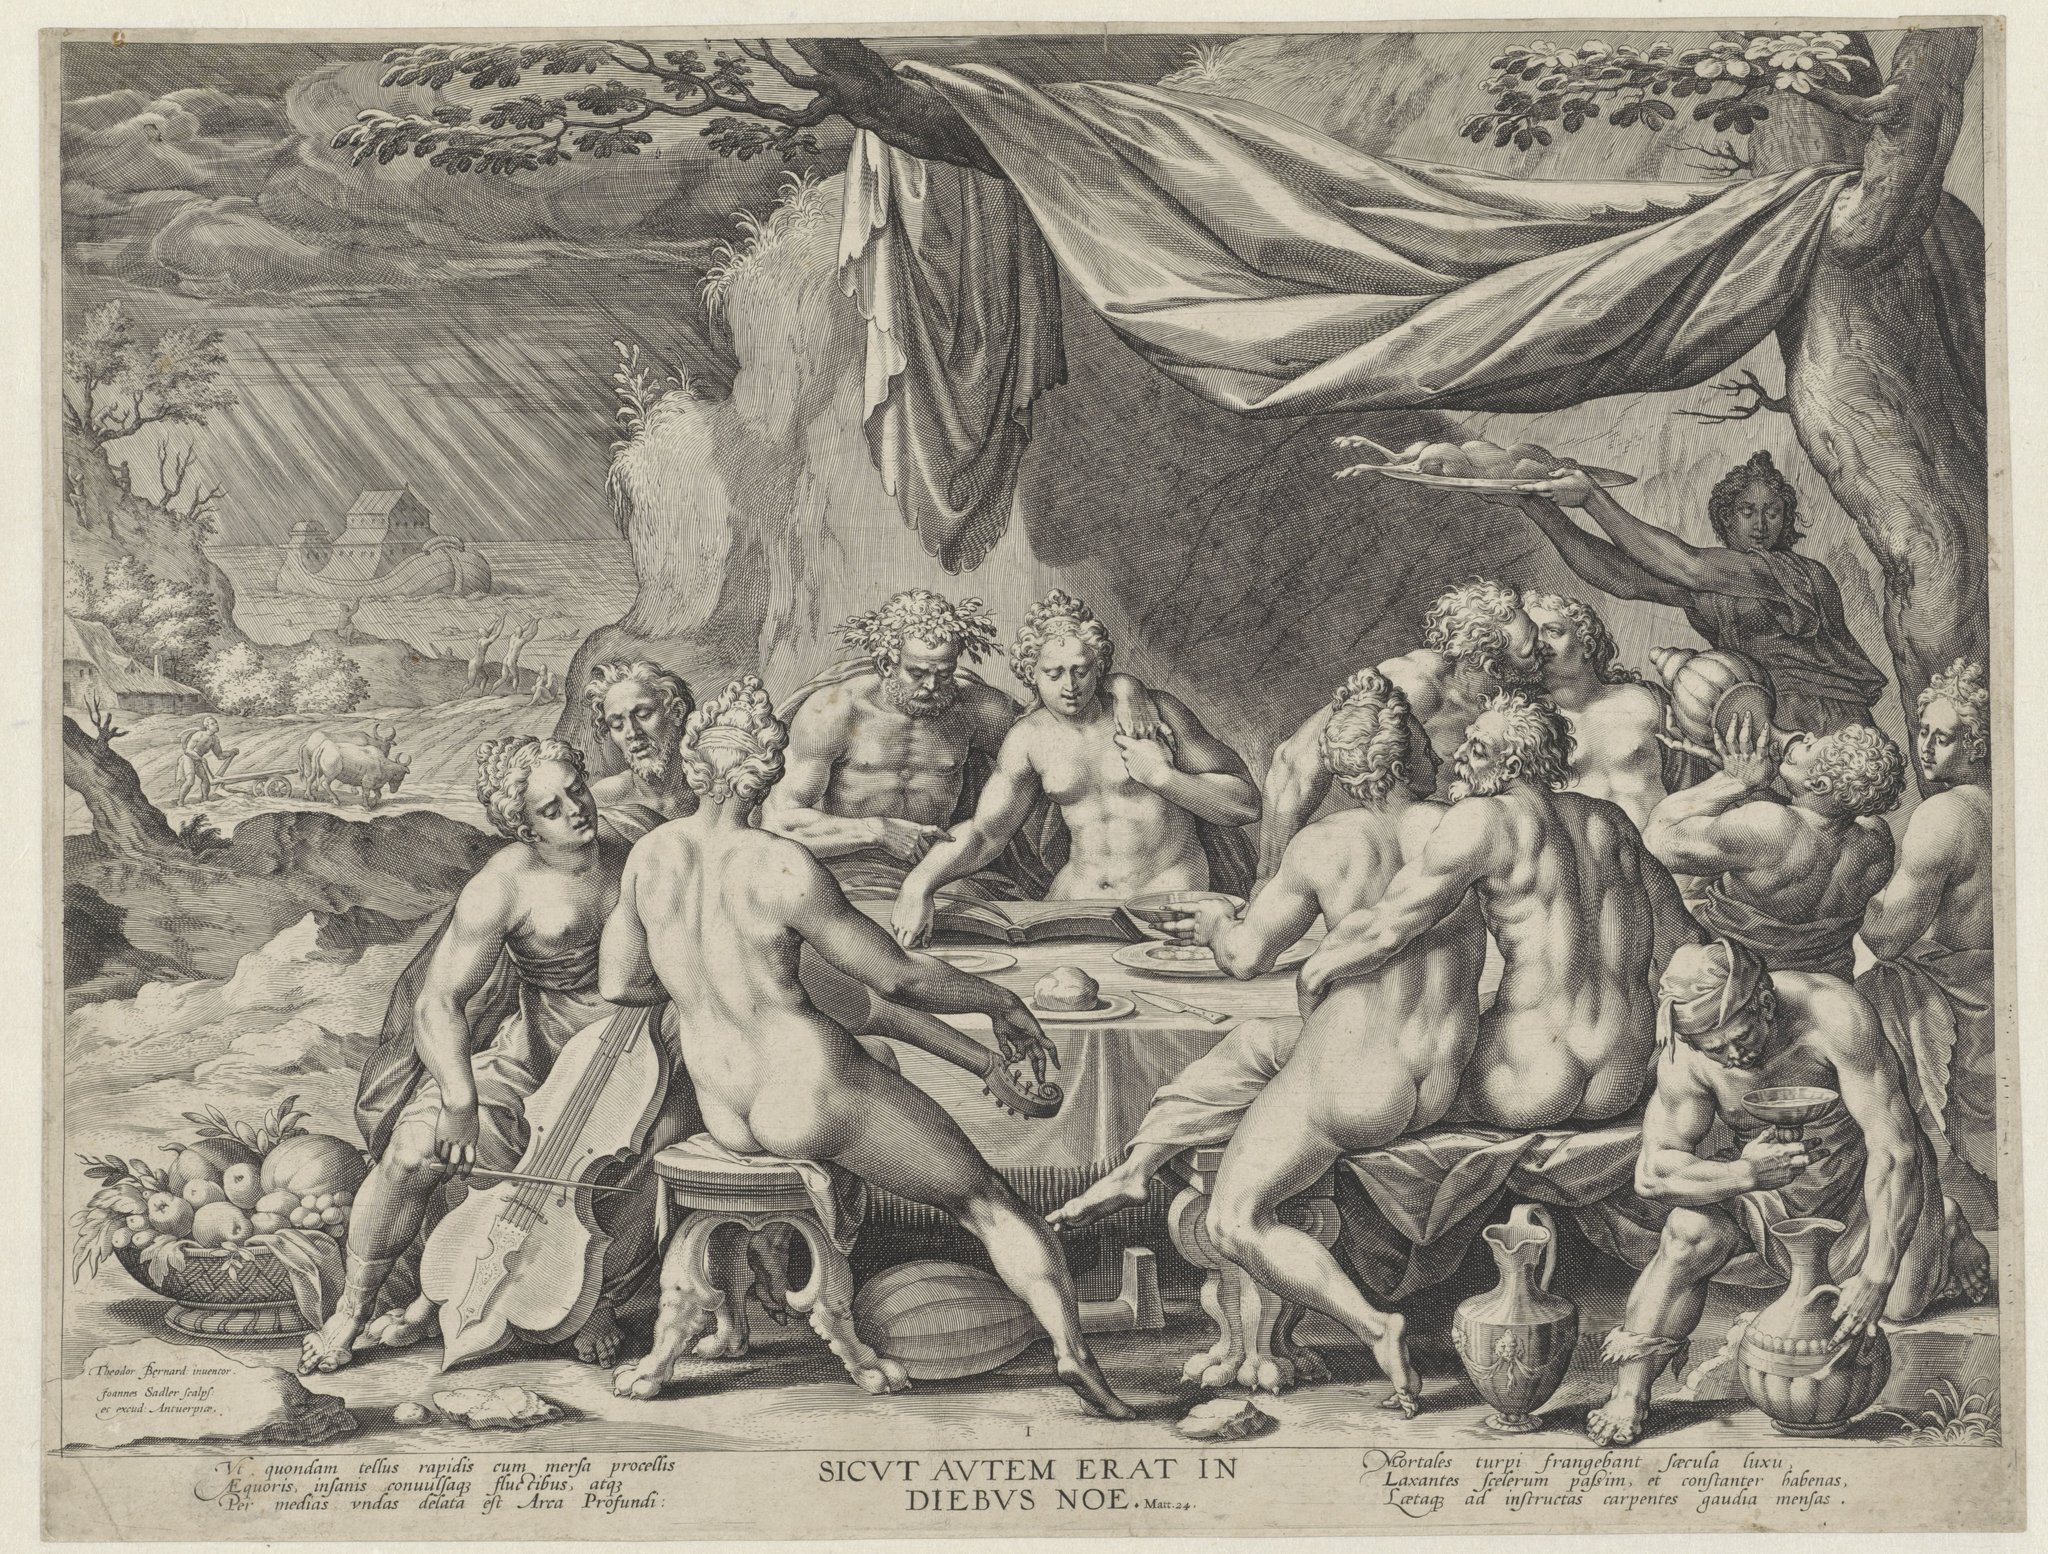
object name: print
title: Sicvt avtem erat in diebvs noe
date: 1581-1583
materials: paper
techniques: engraving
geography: antwerp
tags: the ark is floating on the waters, while life on earth is destroyed ~ story of noah, celebration meal, feast, banquet, the wickedness of mankind; the wicked are usually shown feasting and revelling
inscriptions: collector's mark: Lugt 2228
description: Een groep naakte mensen aan een gedekte tafel in de open lucht. Ze feesten, maken muziek, eten en plegen ontucht. Linksachter de zondvloed met de ark. De prent heeft een Latijns onderschrift met uitleg.